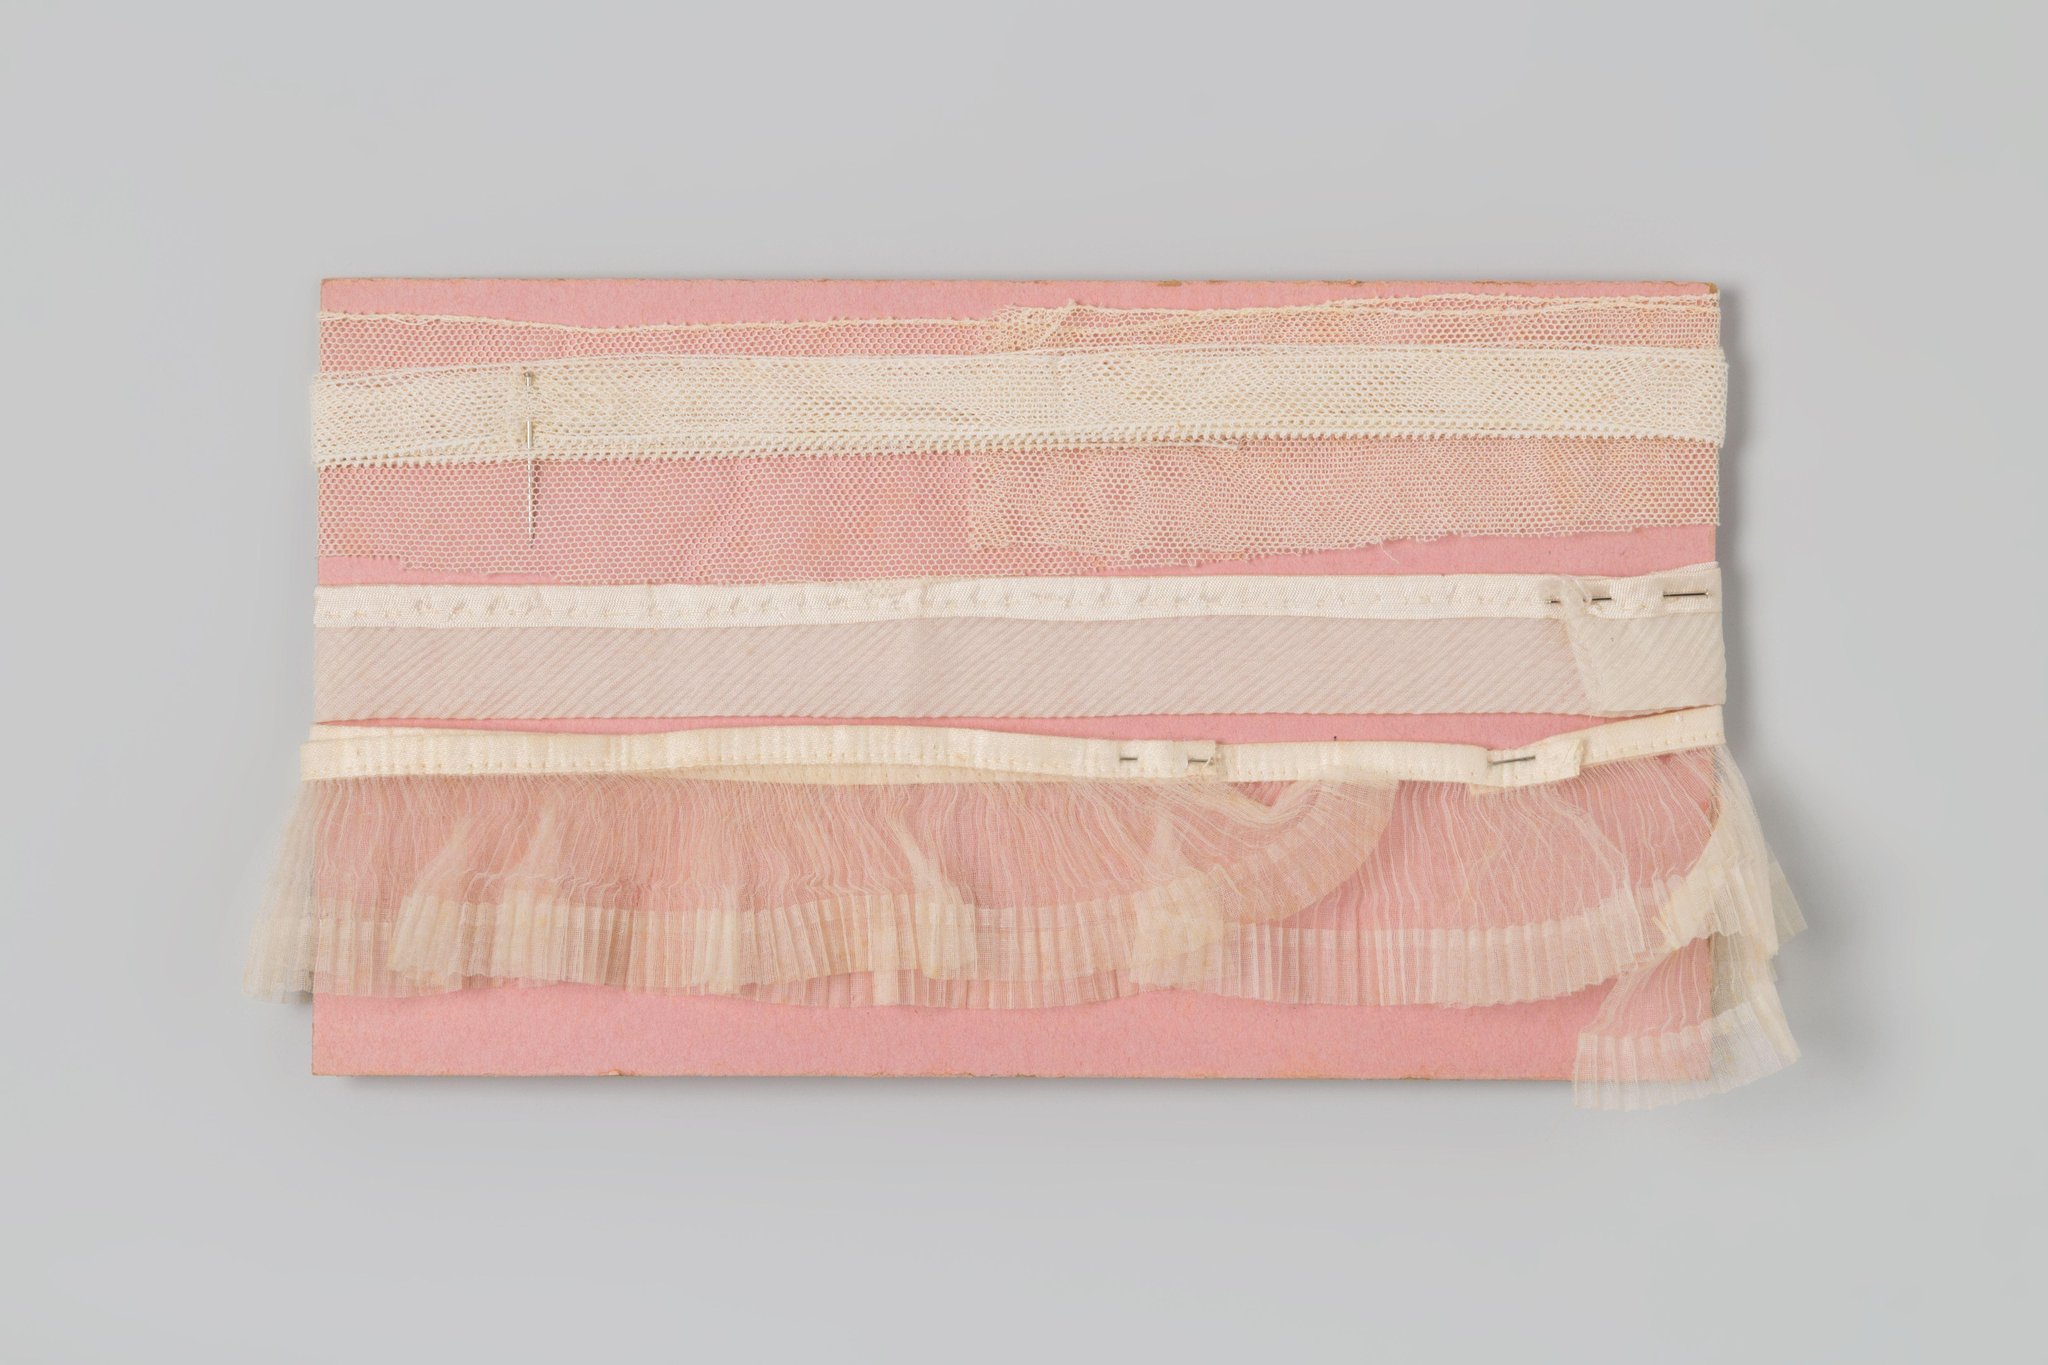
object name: ribbon material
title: Drie witte ruches gewonden om een rose stuk karton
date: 1890-1930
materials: cardboard, textile, silk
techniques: pleated, weave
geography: paris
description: Drie witte ruches gewonden om een rose stuk karton. Op de rose kartonnen kaart zitten een geplisseerde witte zijden gazen ruche met zoom met een satijnen boord en een glad, smal wit boordje van schuin genomen geribde zijden crêpe met een zijden lintboordje en twee witte tulen en met picots afgewerkte gladde bandjes.